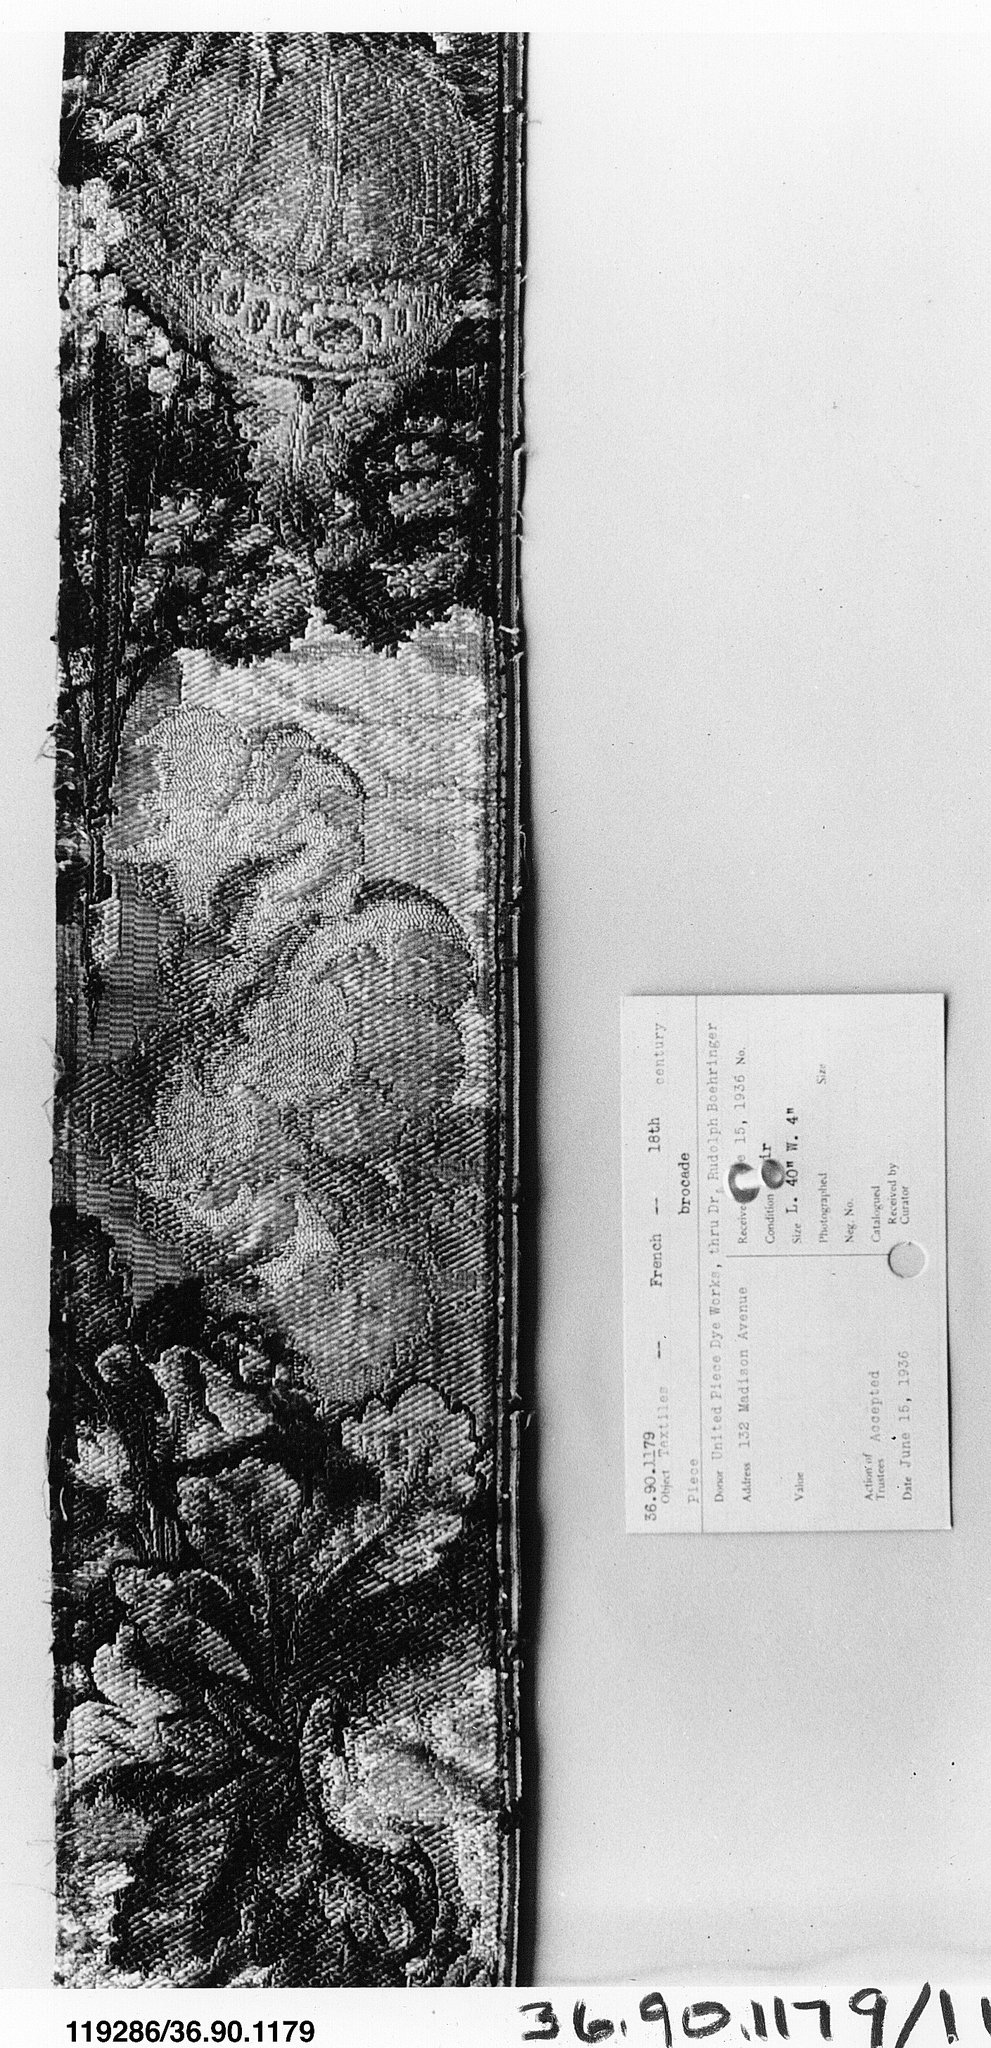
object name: piece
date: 1701-1750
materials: metal thread, silk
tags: flowers,leaves